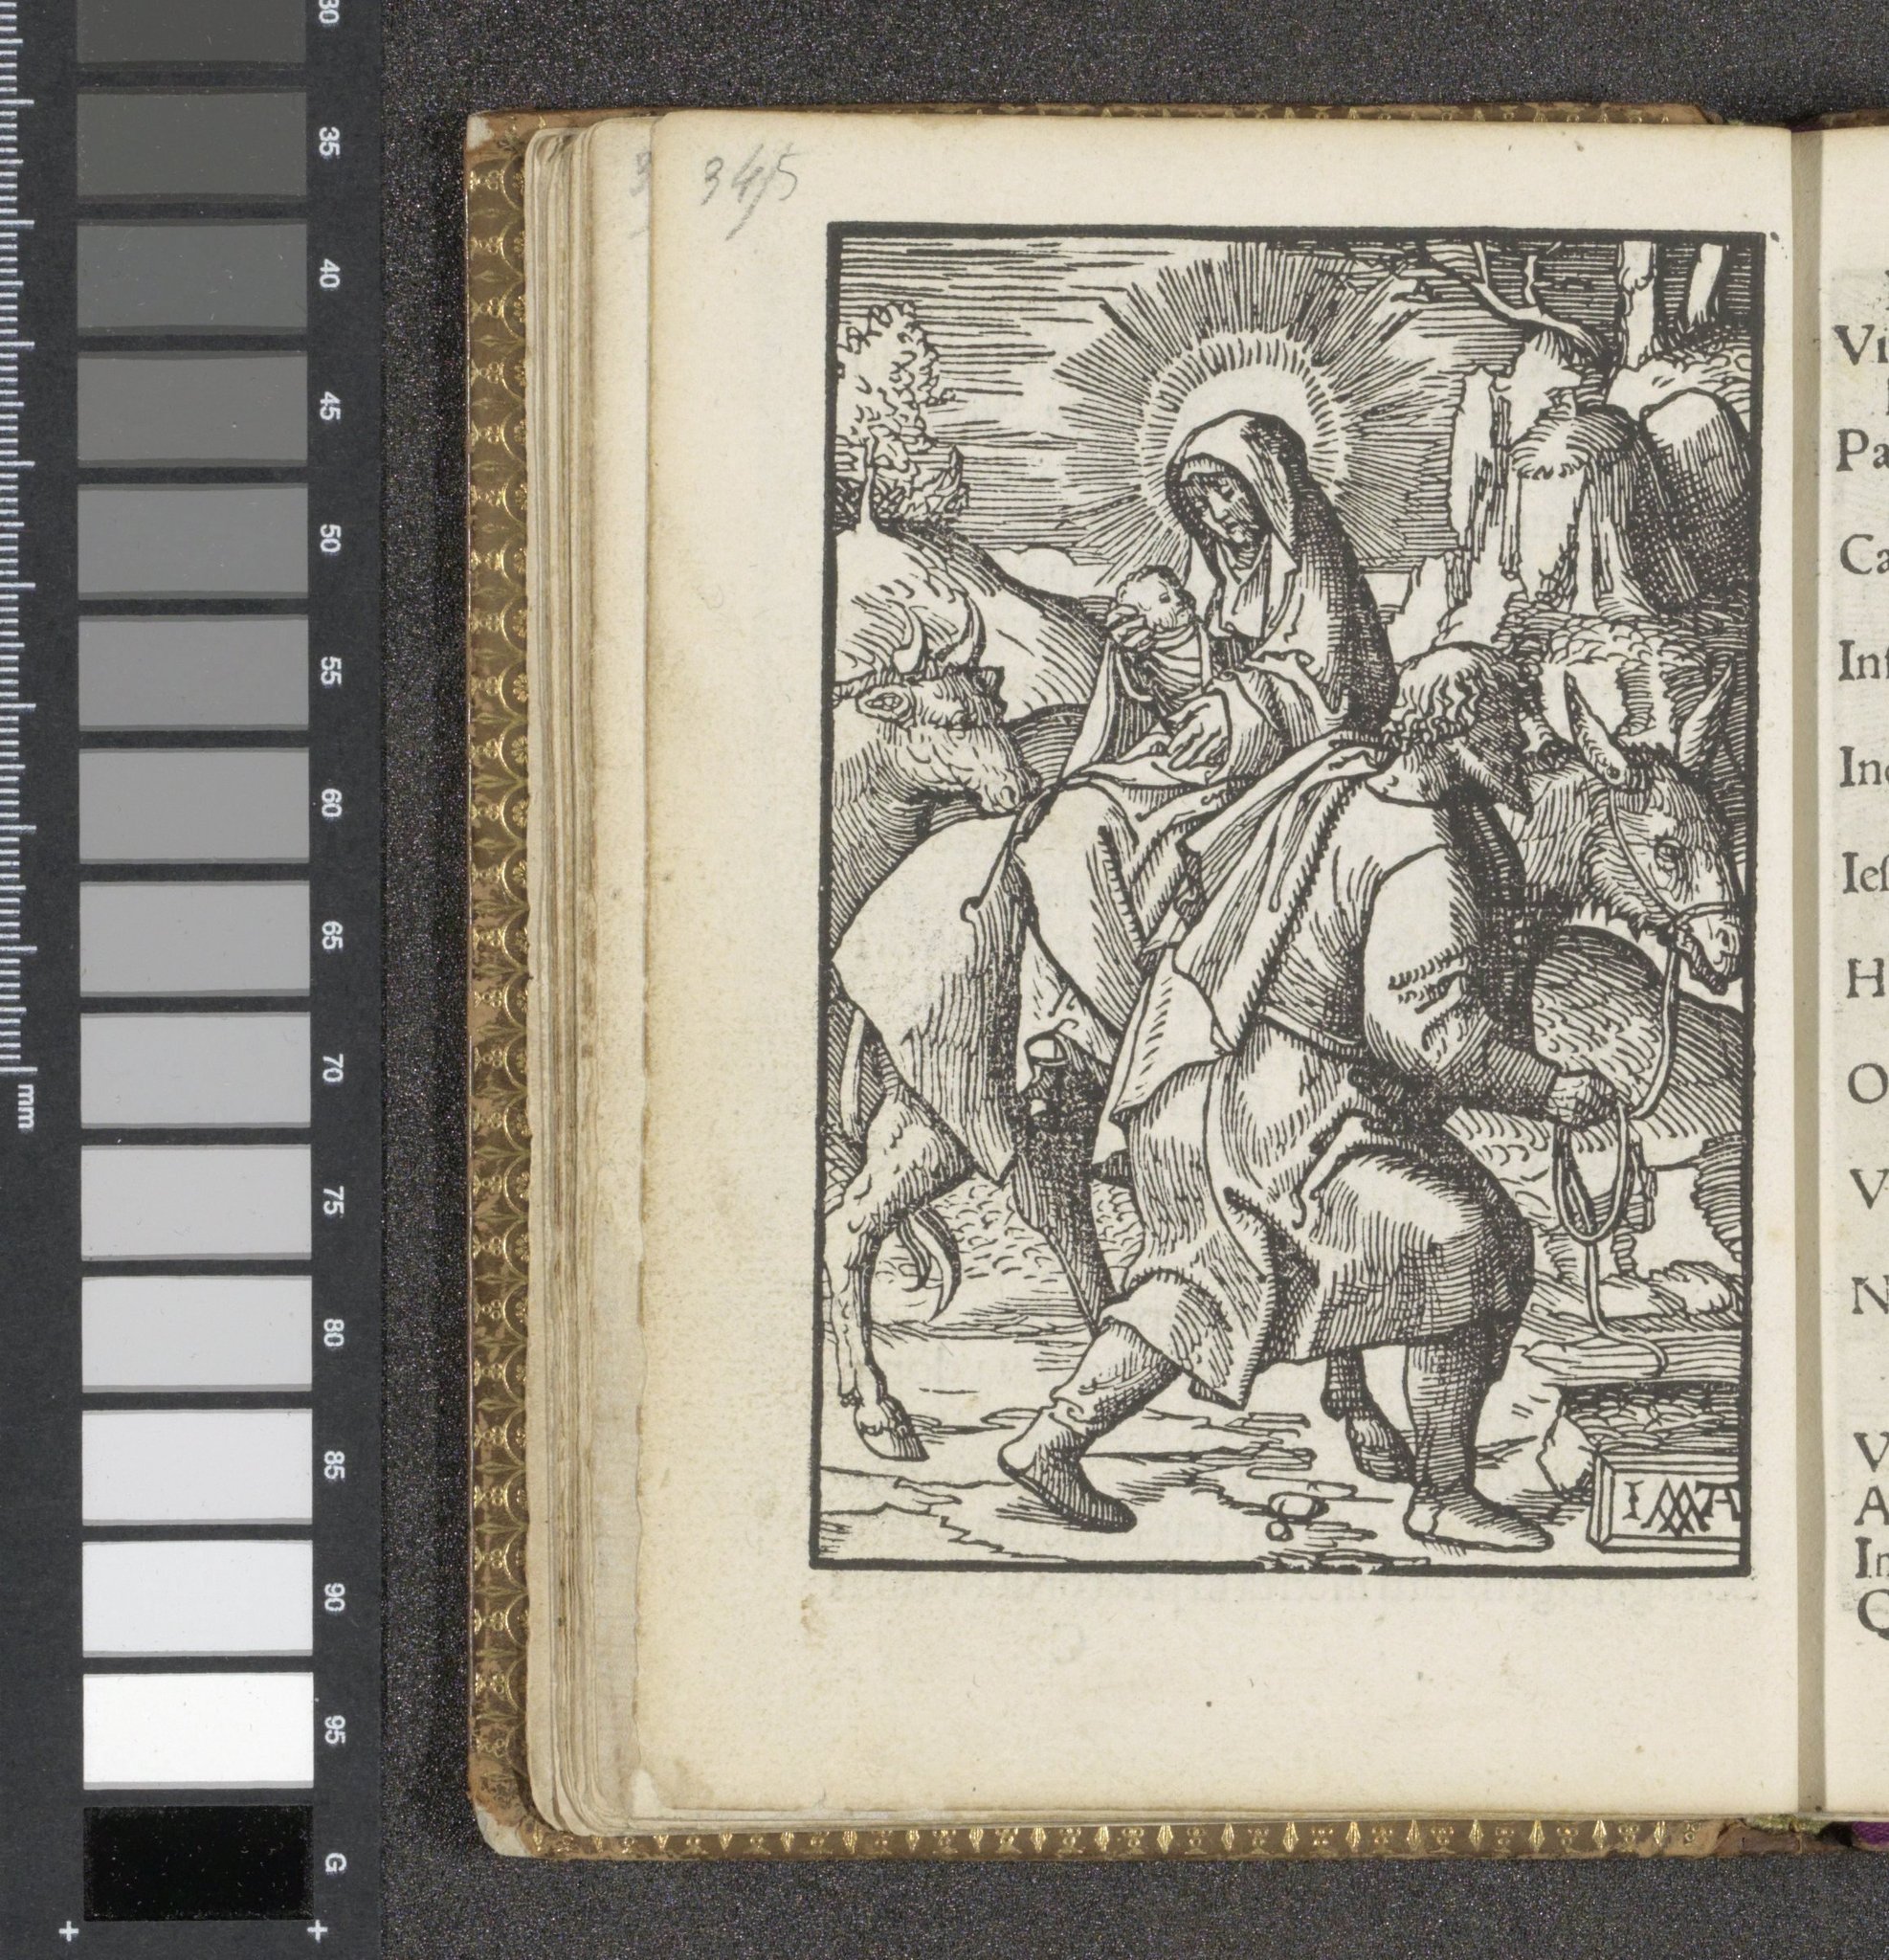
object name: print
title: De kleine Passie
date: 1523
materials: paper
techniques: woodcut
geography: amsterdam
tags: the flight into egypt: mary, joseph, the child (and sometimes others) on their way; mary usually riding on an ass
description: Maria zit met het Christuskind in haar armen op de ezel, die door Jozef wordt voortgeleid. Prent maakt deel uit van een boek.